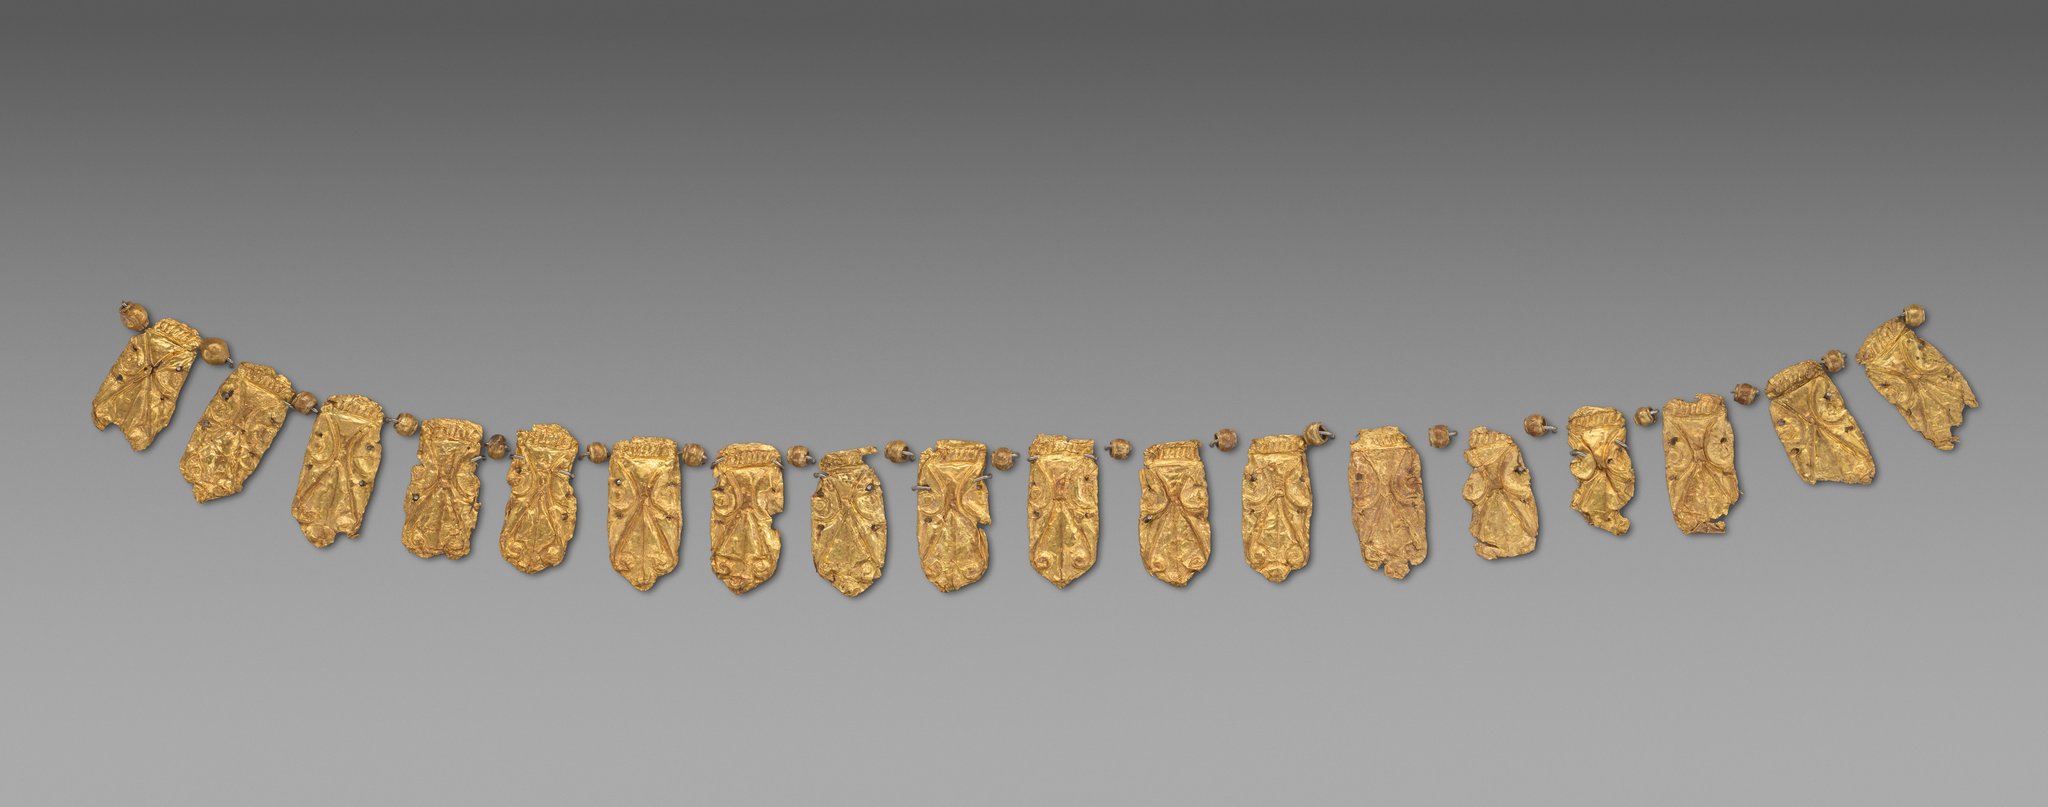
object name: necklace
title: Gold necklace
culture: aegean or cypriot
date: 1400-1200 BCE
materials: gold